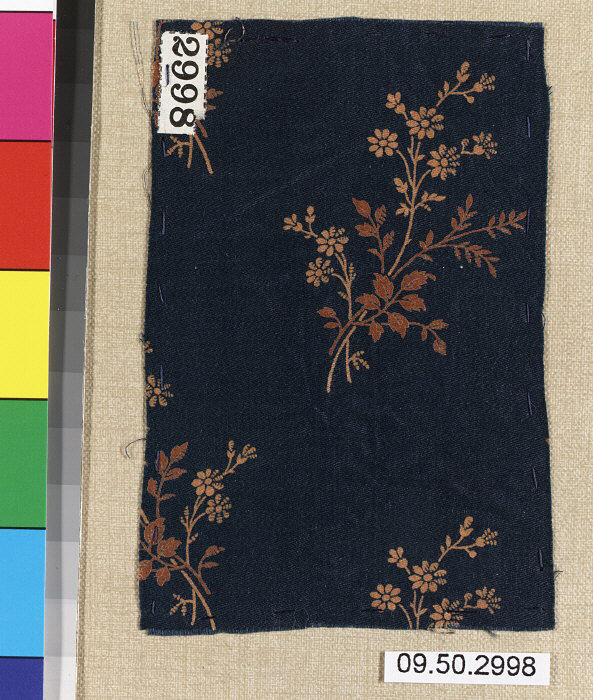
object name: piece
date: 1801-1900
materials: cotton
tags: flowers,leaves